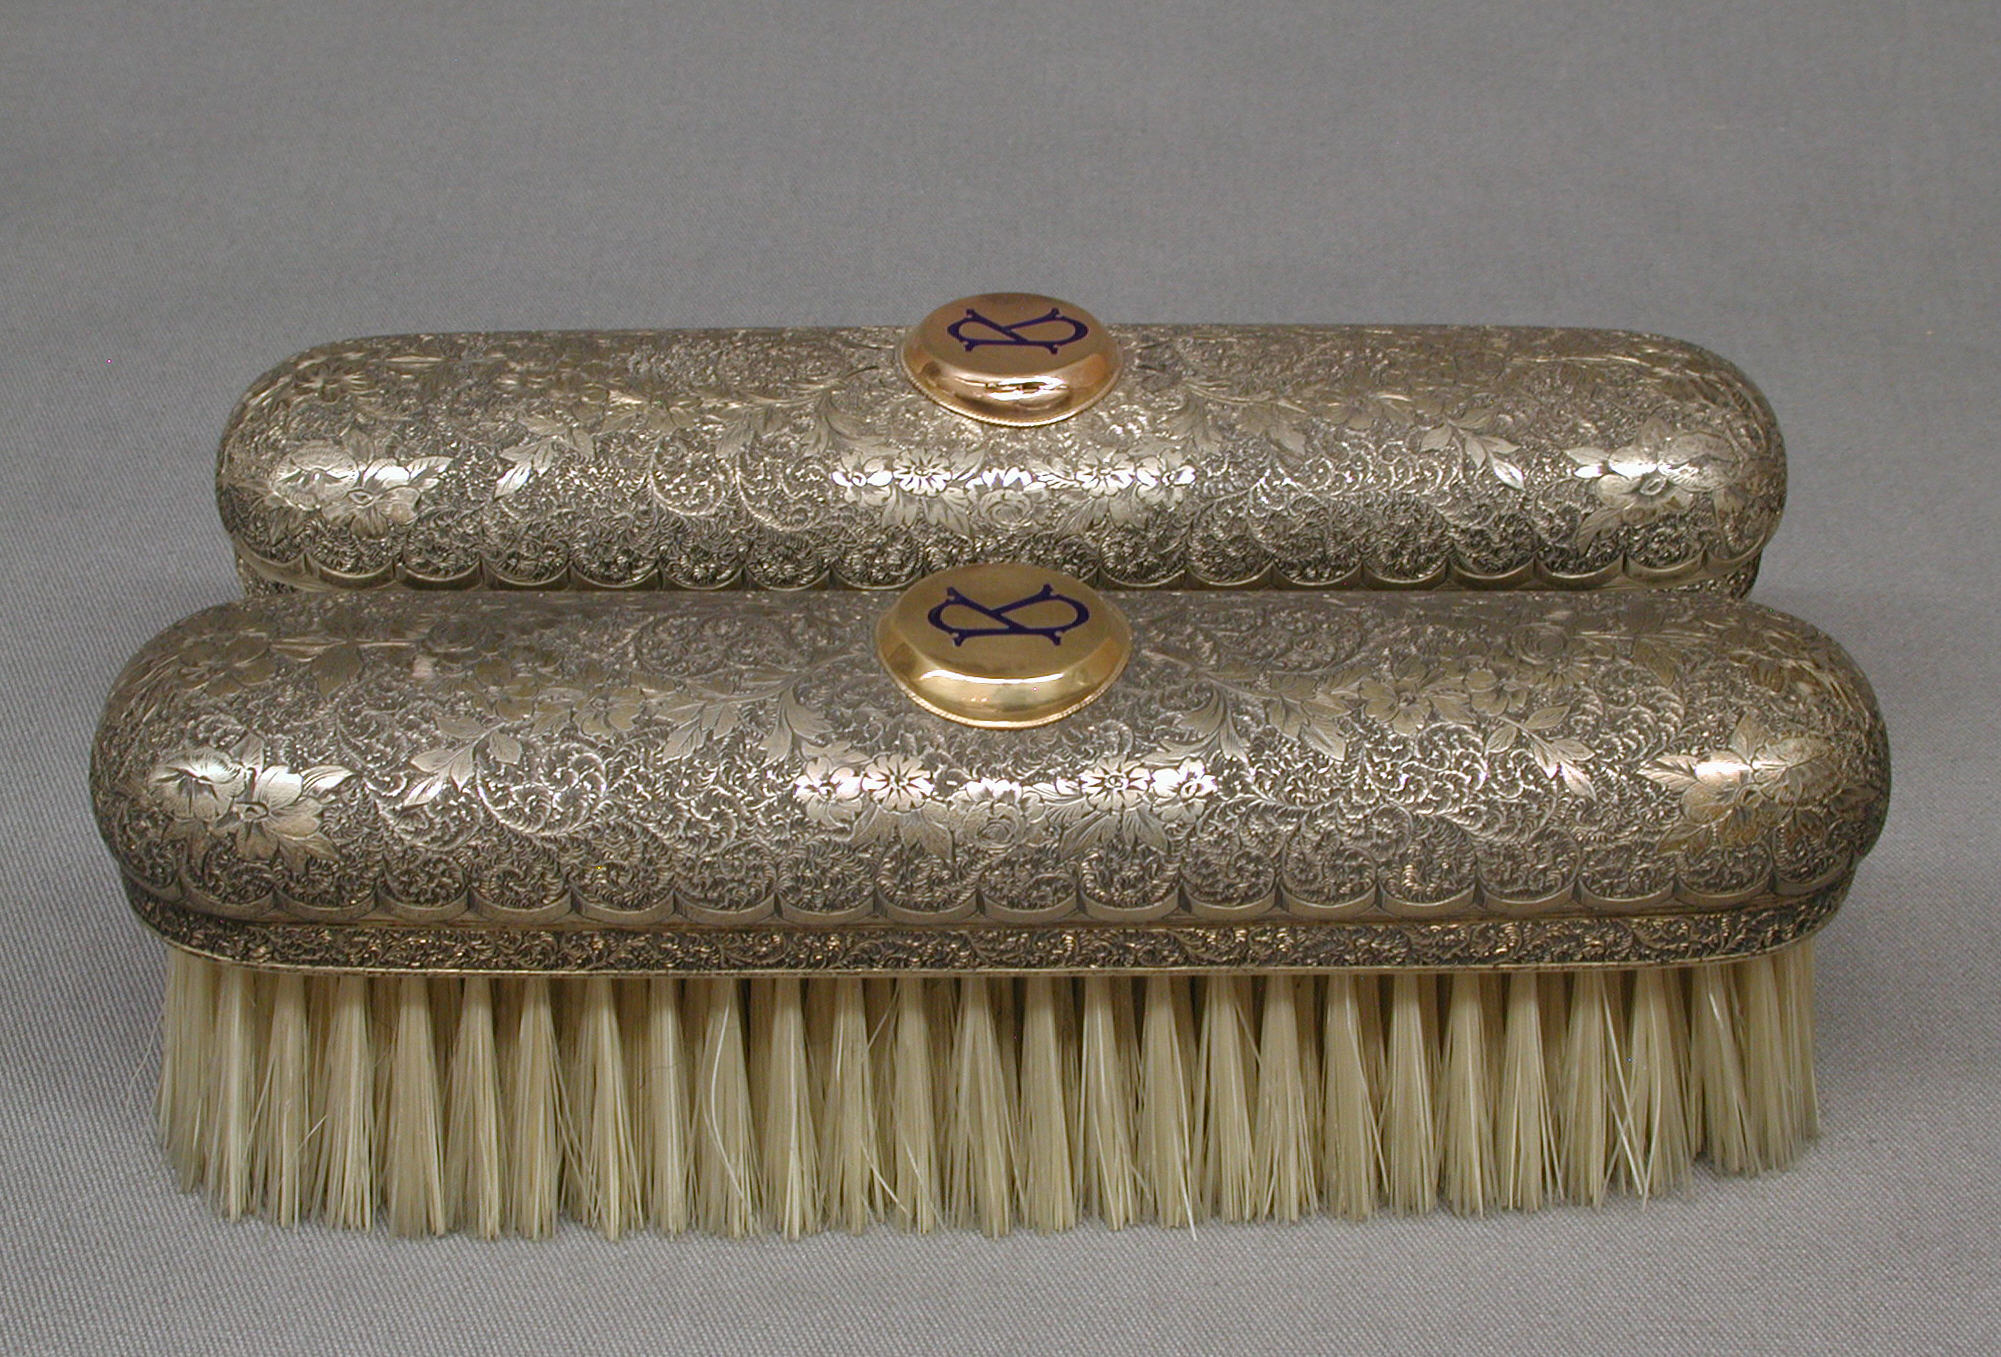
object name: clothes brush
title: Clothes brush (one of a pair)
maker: barnard brothers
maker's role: maker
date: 1874-1875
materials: silver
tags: flowers